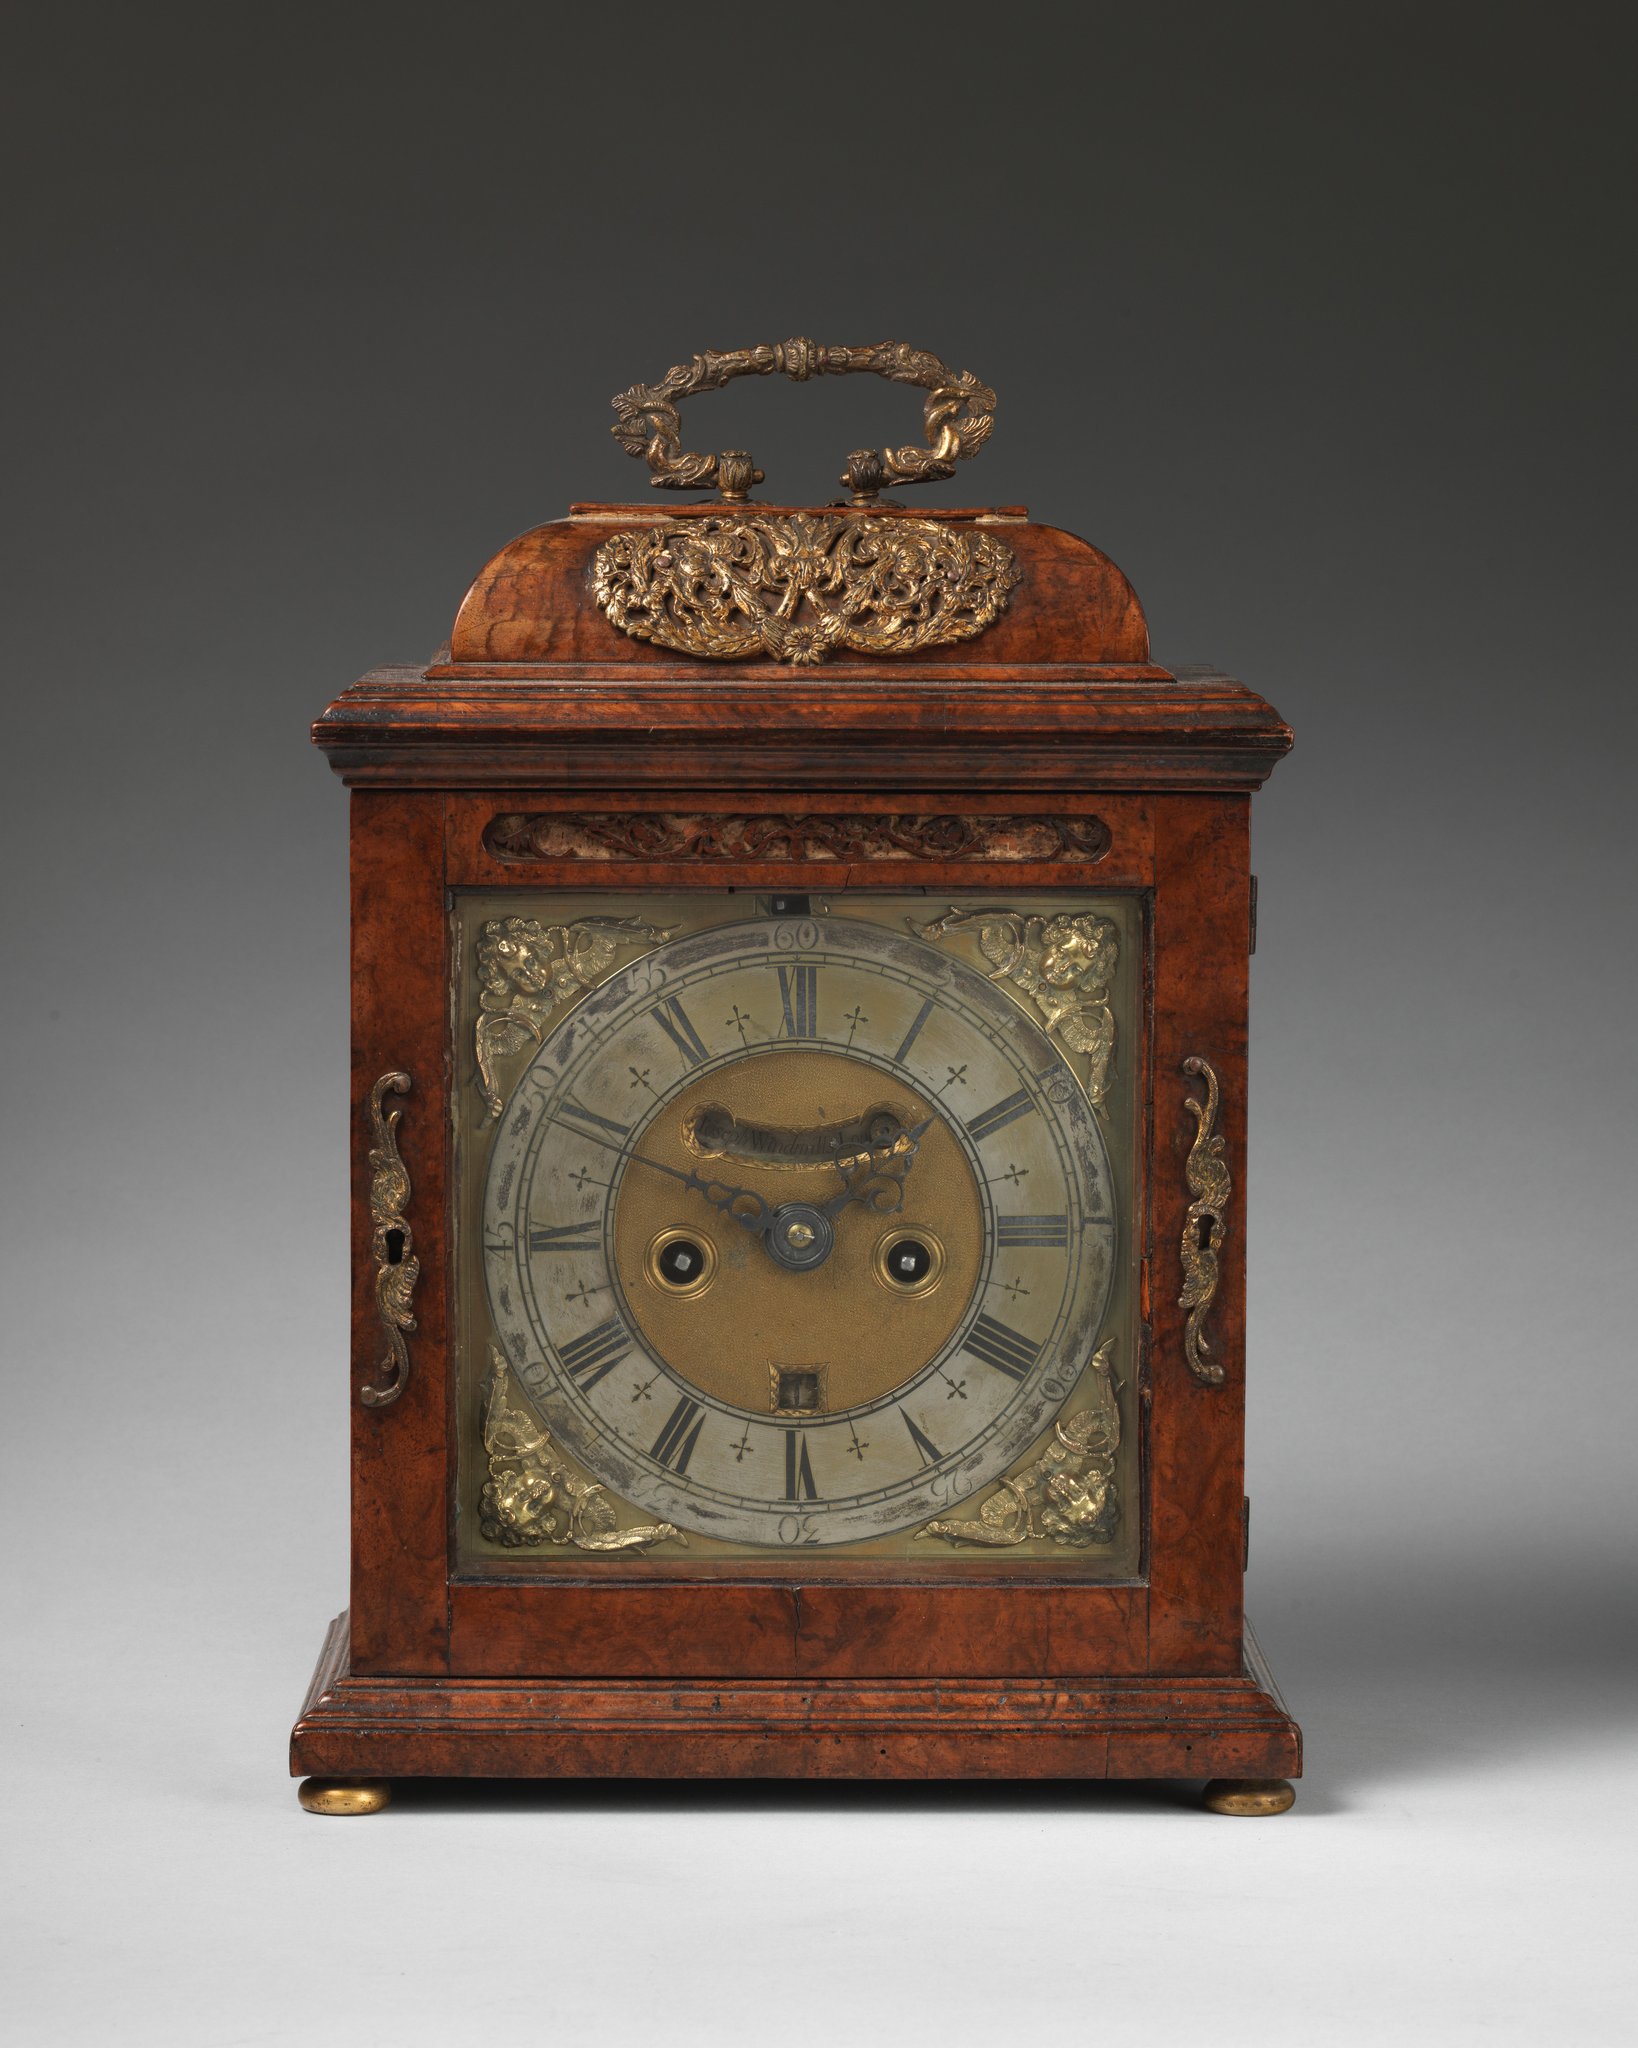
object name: table or bracket clock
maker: joseph windmills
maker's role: maker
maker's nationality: british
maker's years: 1641-1753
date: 1700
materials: gilt bronze, wood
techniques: veneering